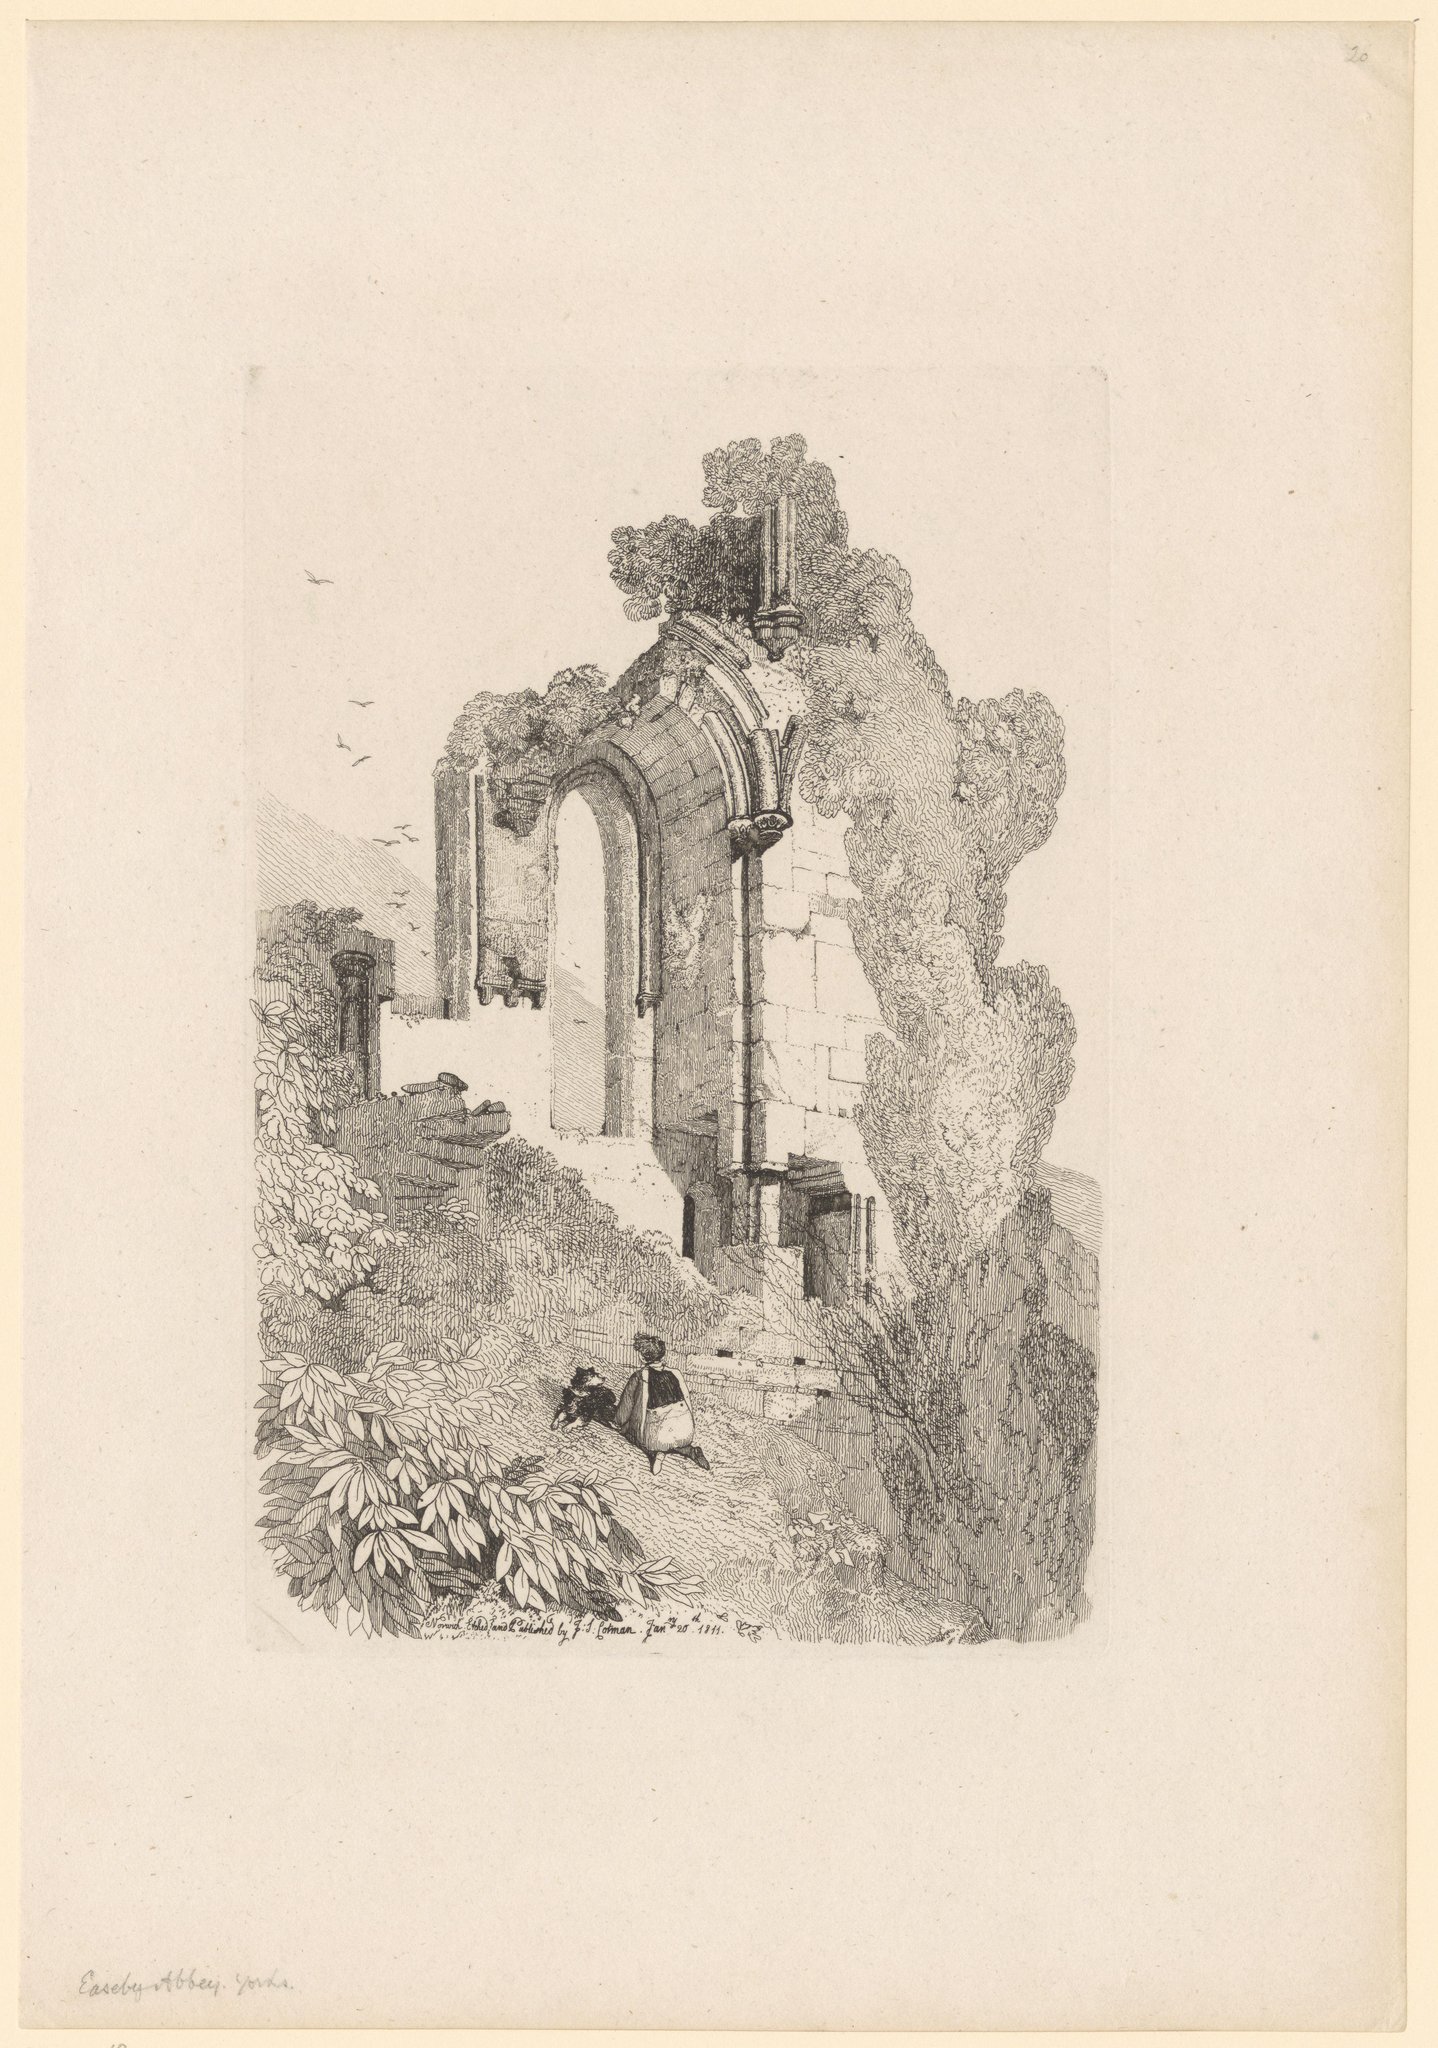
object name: print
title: Kind zit met een hond voor een venster van de ruïne van de Easby Abbey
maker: john sell cotman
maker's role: draughtsman, print maker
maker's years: 1782-1842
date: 1801-1811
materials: paper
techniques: etching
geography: norwich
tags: child, ruin of church, monastery, etc., resting - bb - out of doors, dog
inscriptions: collector's mark: Lugt 2760, collector's mark: Lugt 2228